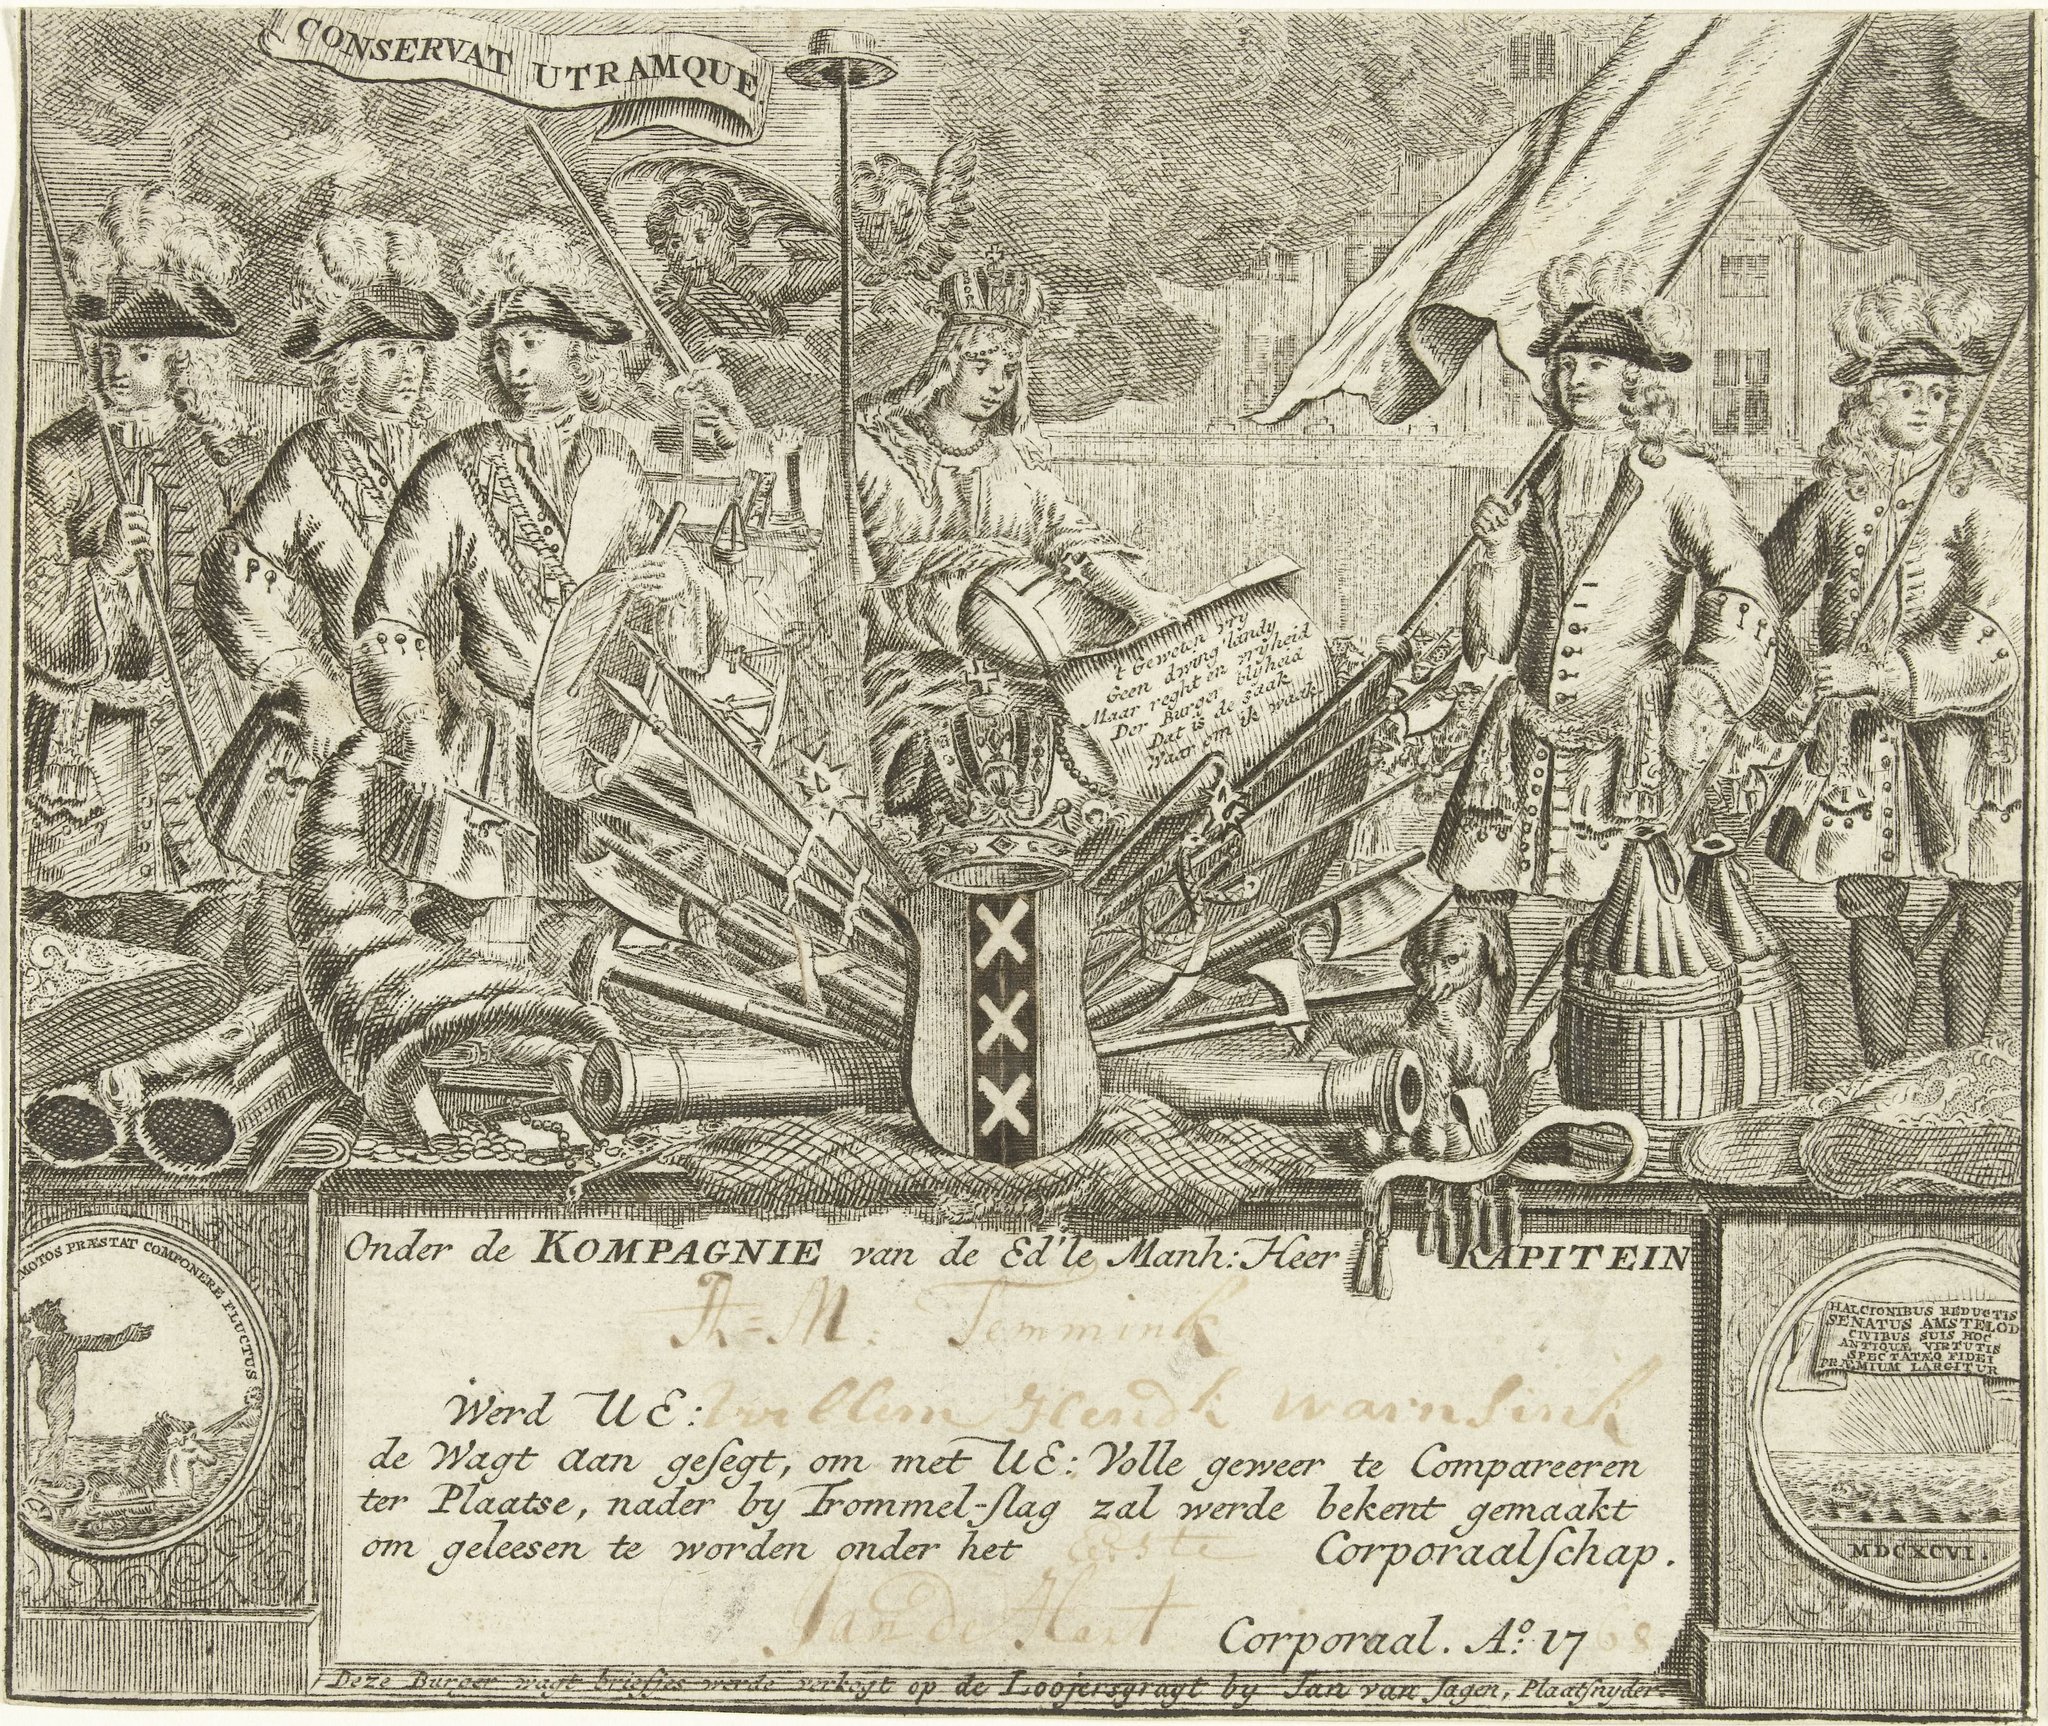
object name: schuttersbiljet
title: Schuttersbrief voor Willem Hendrik Warnsink, 1768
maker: jan van jagen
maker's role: print maker, publisher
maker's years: 1709-1800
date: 1768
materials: paper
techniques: engraving, writing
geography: amsterdam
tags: warfare; military affairs (+ citizen soldiery, civil guard, citizen militia), amsterdam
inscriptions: collector's mark: Lugt 2228, collector's mark: Lugt 2760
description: Schuttersbrief of burgerwachtbrief voor Willem Hendrik Warnsink, dienende in de compagnie onder de kapitein Th.M. Temmink, om zich bij het eerste korporaalschap van Jan de Hart (?) van de schutterij te Amsterdam te melden, 1768. Voorgedrukte brief versierd met soldaten, de stadsmaagd en wapen van Amsterdam met open delen die met de pen zijn ingevuld.